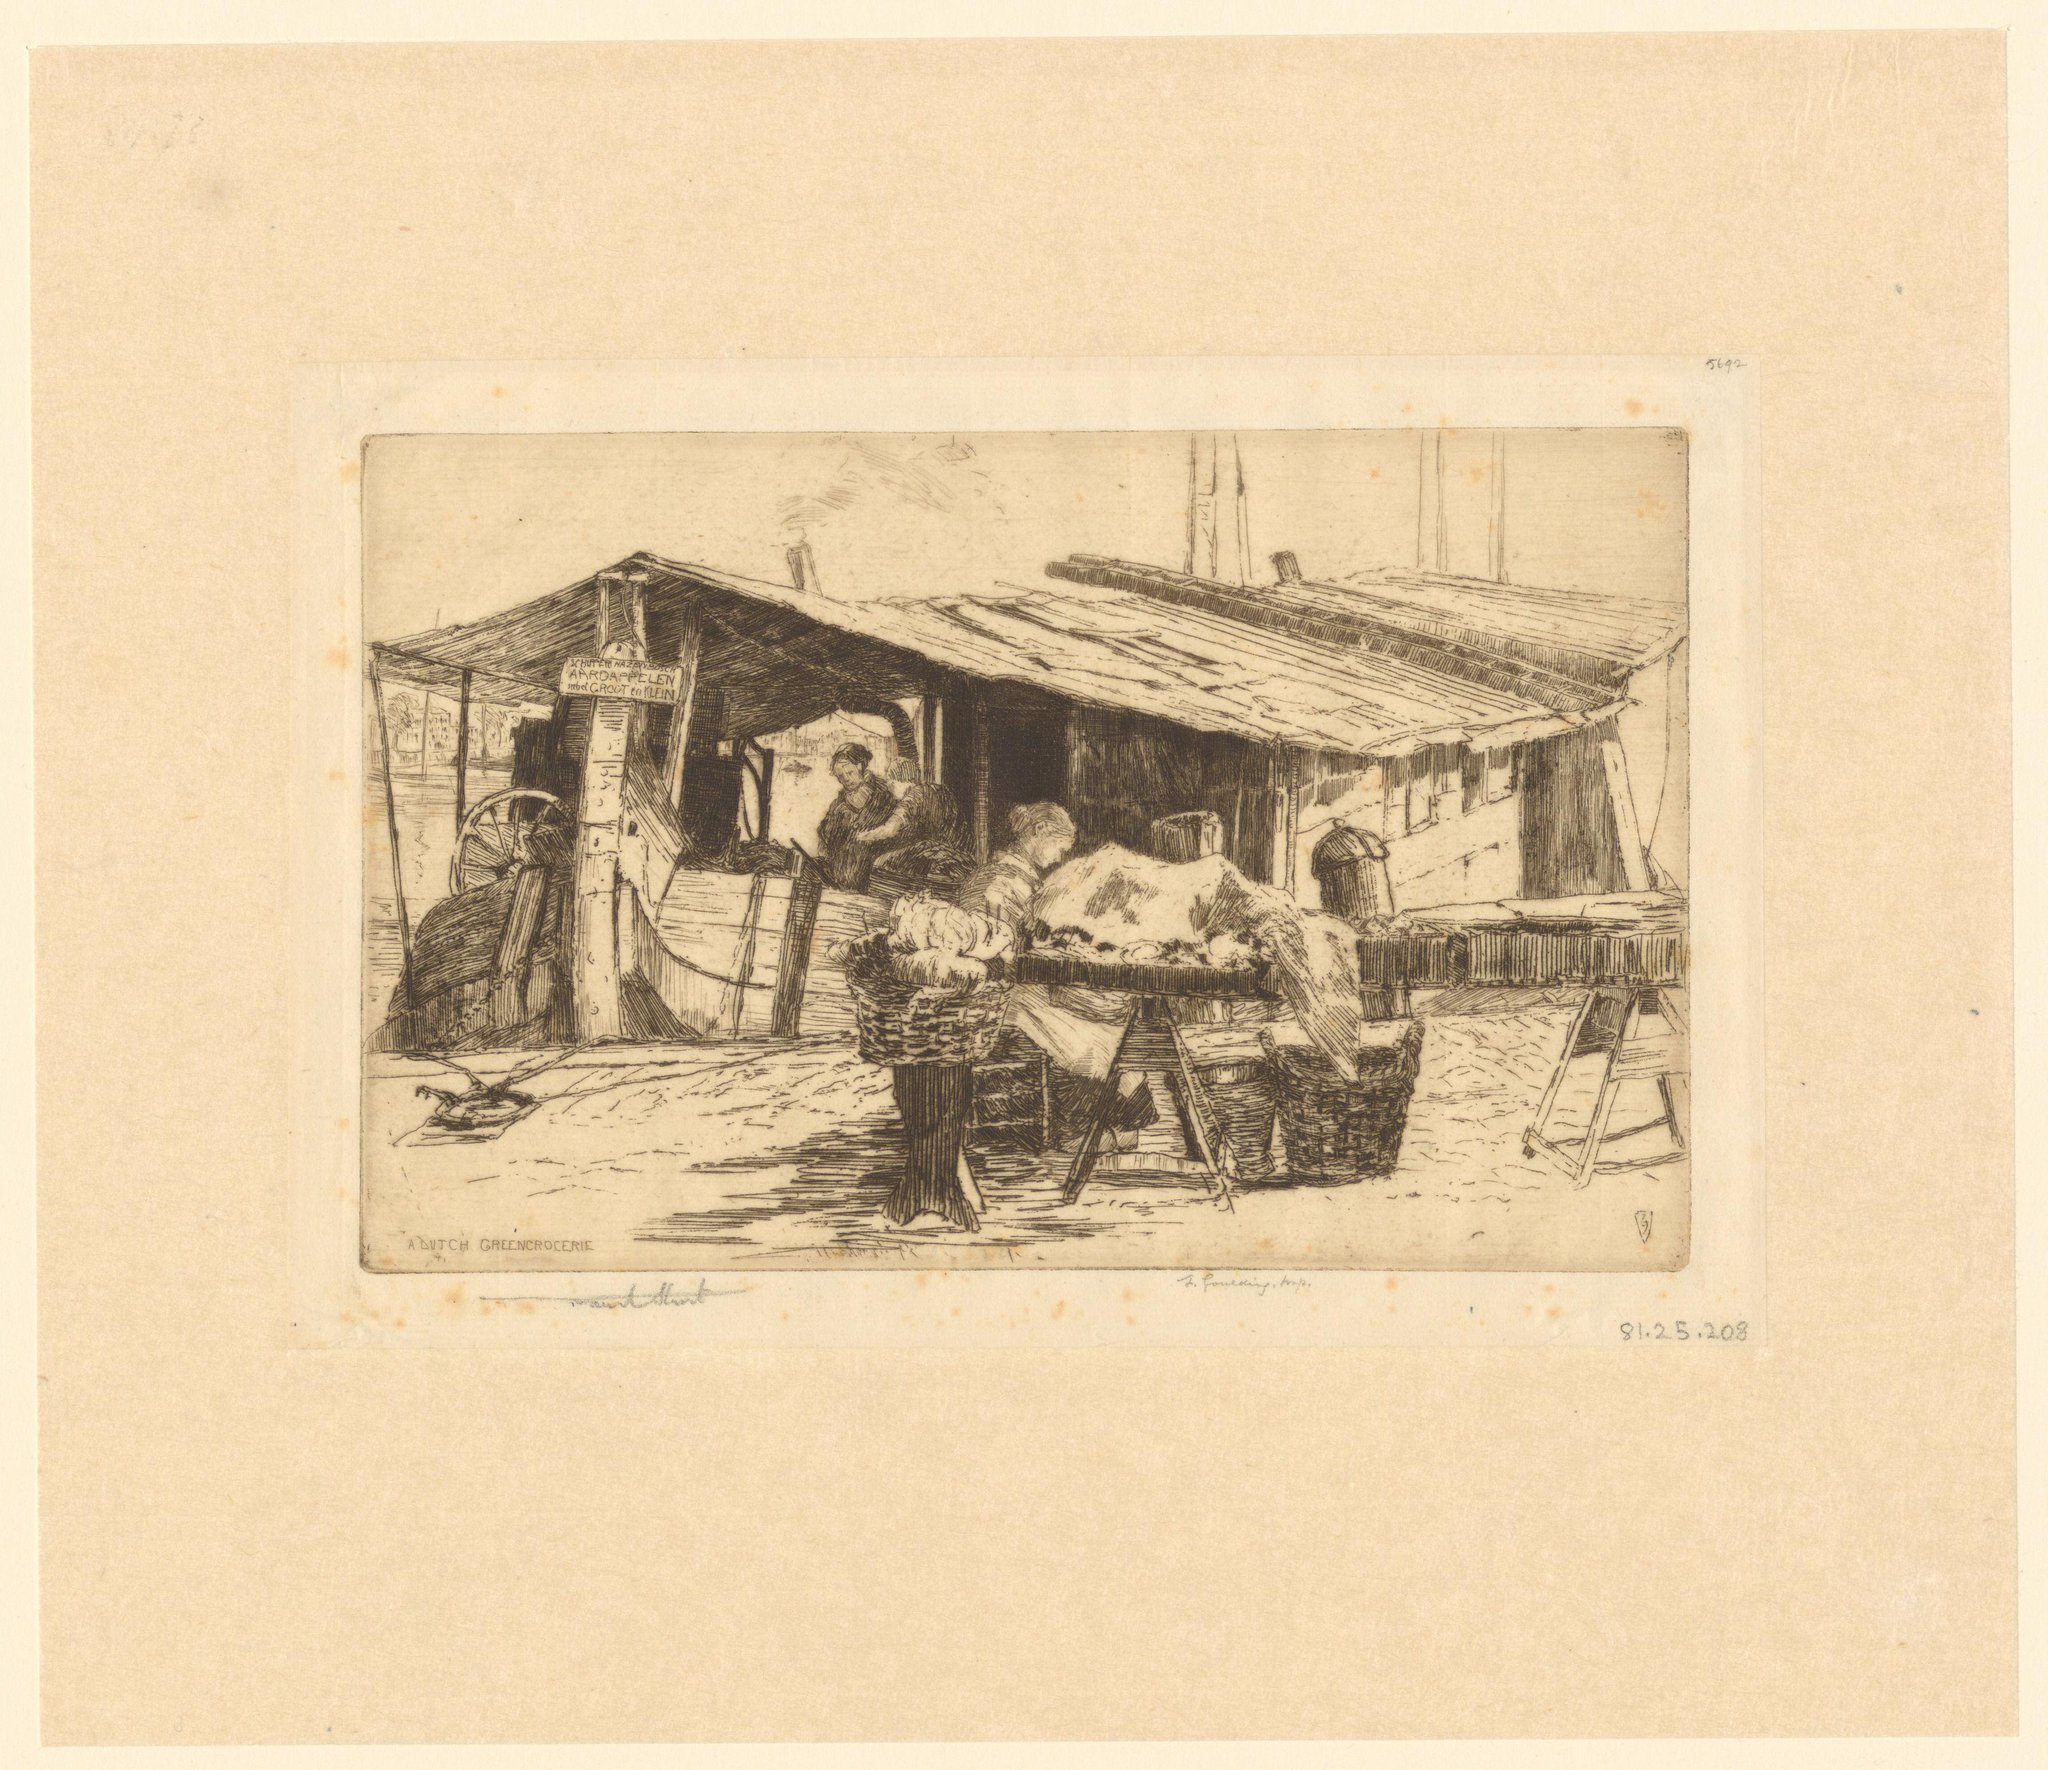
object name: print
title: Drie vrouwen verkopen aardappelen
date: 1889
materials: paper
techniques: etching, intaglio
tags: potatoes, merchant, salesman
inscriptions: collector's mark: Lugt 2228, collector's mark: Lugt 2760, stamp: ‘C.H. [...] (?)’